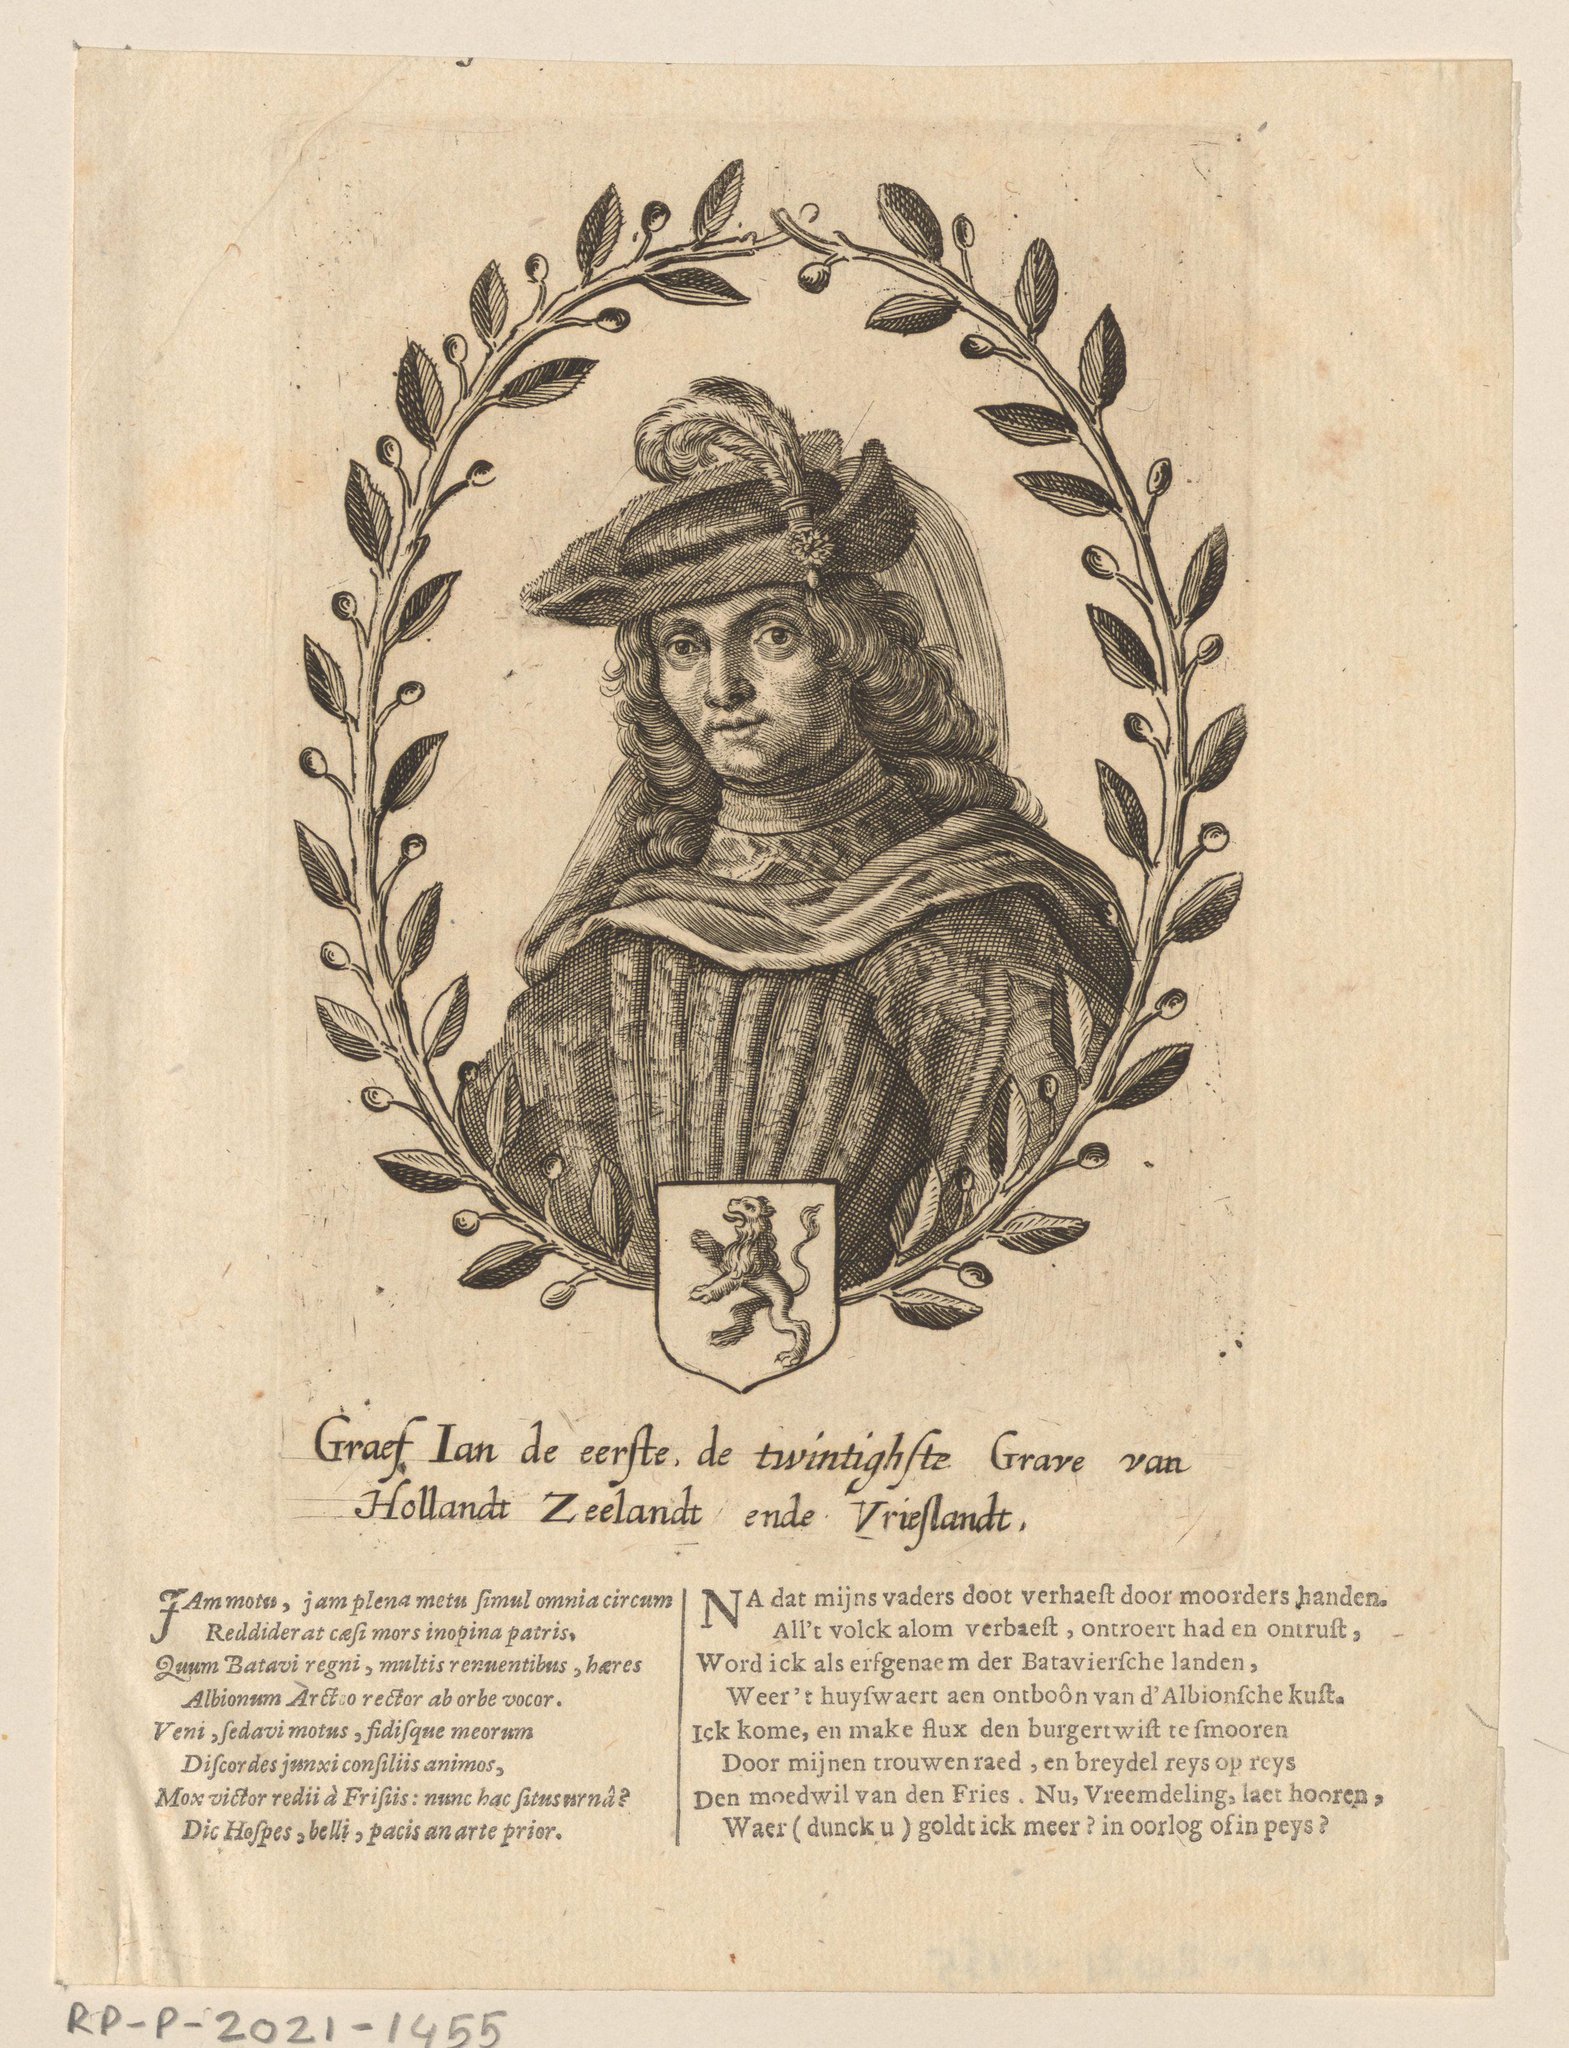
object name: print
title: Portret van Jan I, graaf van Holland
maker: Anonymous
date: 1667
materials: paper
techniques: engraving, etching, letterpress printing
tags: earl, jan i (graaf van holland), historical persons, head-gear: hat, ruler, sovereign, armorial bearing, heraldry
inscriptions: collector's mark: Lugt 964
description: Prent mogelijk uit: Scriverius, Petrus. Alle de graven van Hollant en WestVrieslant. Den Haag: Pieter Brugman, 1667, p. 246. Of uit: Scriverius, Petrus. Oude en nieuwe beschryvinge van Holland, Zeeland en Vriesland (...). Den Haag: Pieter Brughman, 1667, dl. 1, p. 146.